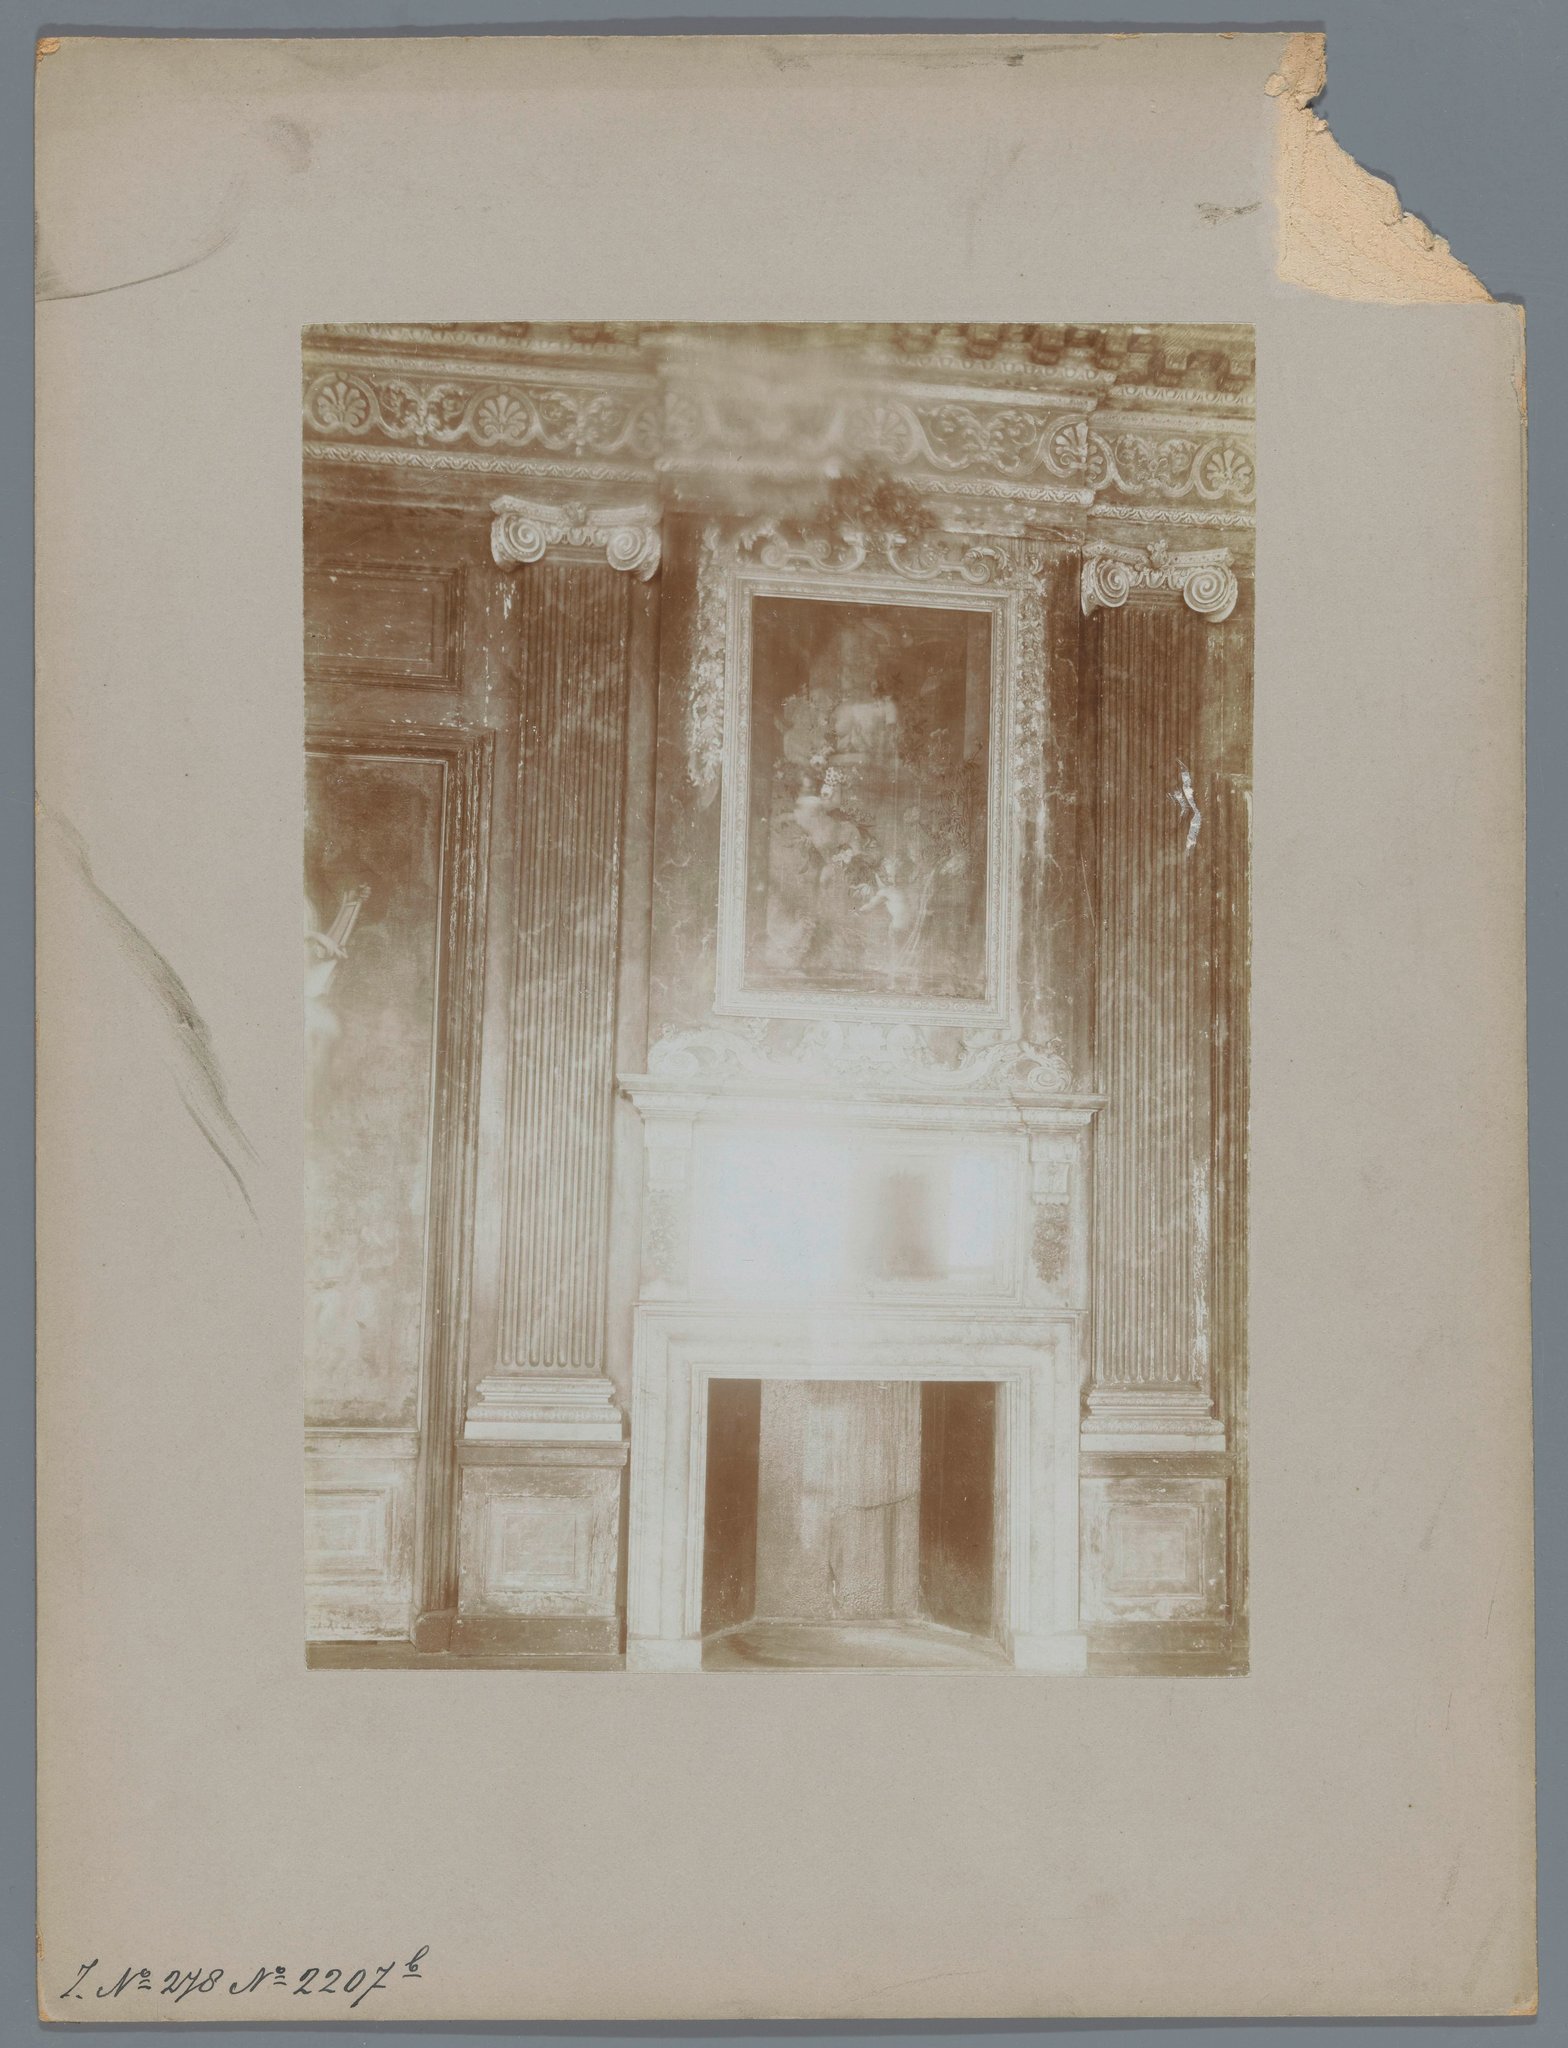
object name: photograph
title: Schouw met een spiegel en een schilderij in een huis aan het Noordeinde te Den Haag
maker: Anonymous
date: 1901-1912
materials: cardboard, photographic support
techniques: collodion silver print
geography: noordeinde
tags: mirror, open hearth, fire-place, picture, painting, interior ~ representation of a building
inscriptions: inscription: ‘7286 neg. no 15061’, inscription: ‘[...]steen in koepel van voorm. huis Fagel Noordeinde den Haag Jan. 1912’, annotation